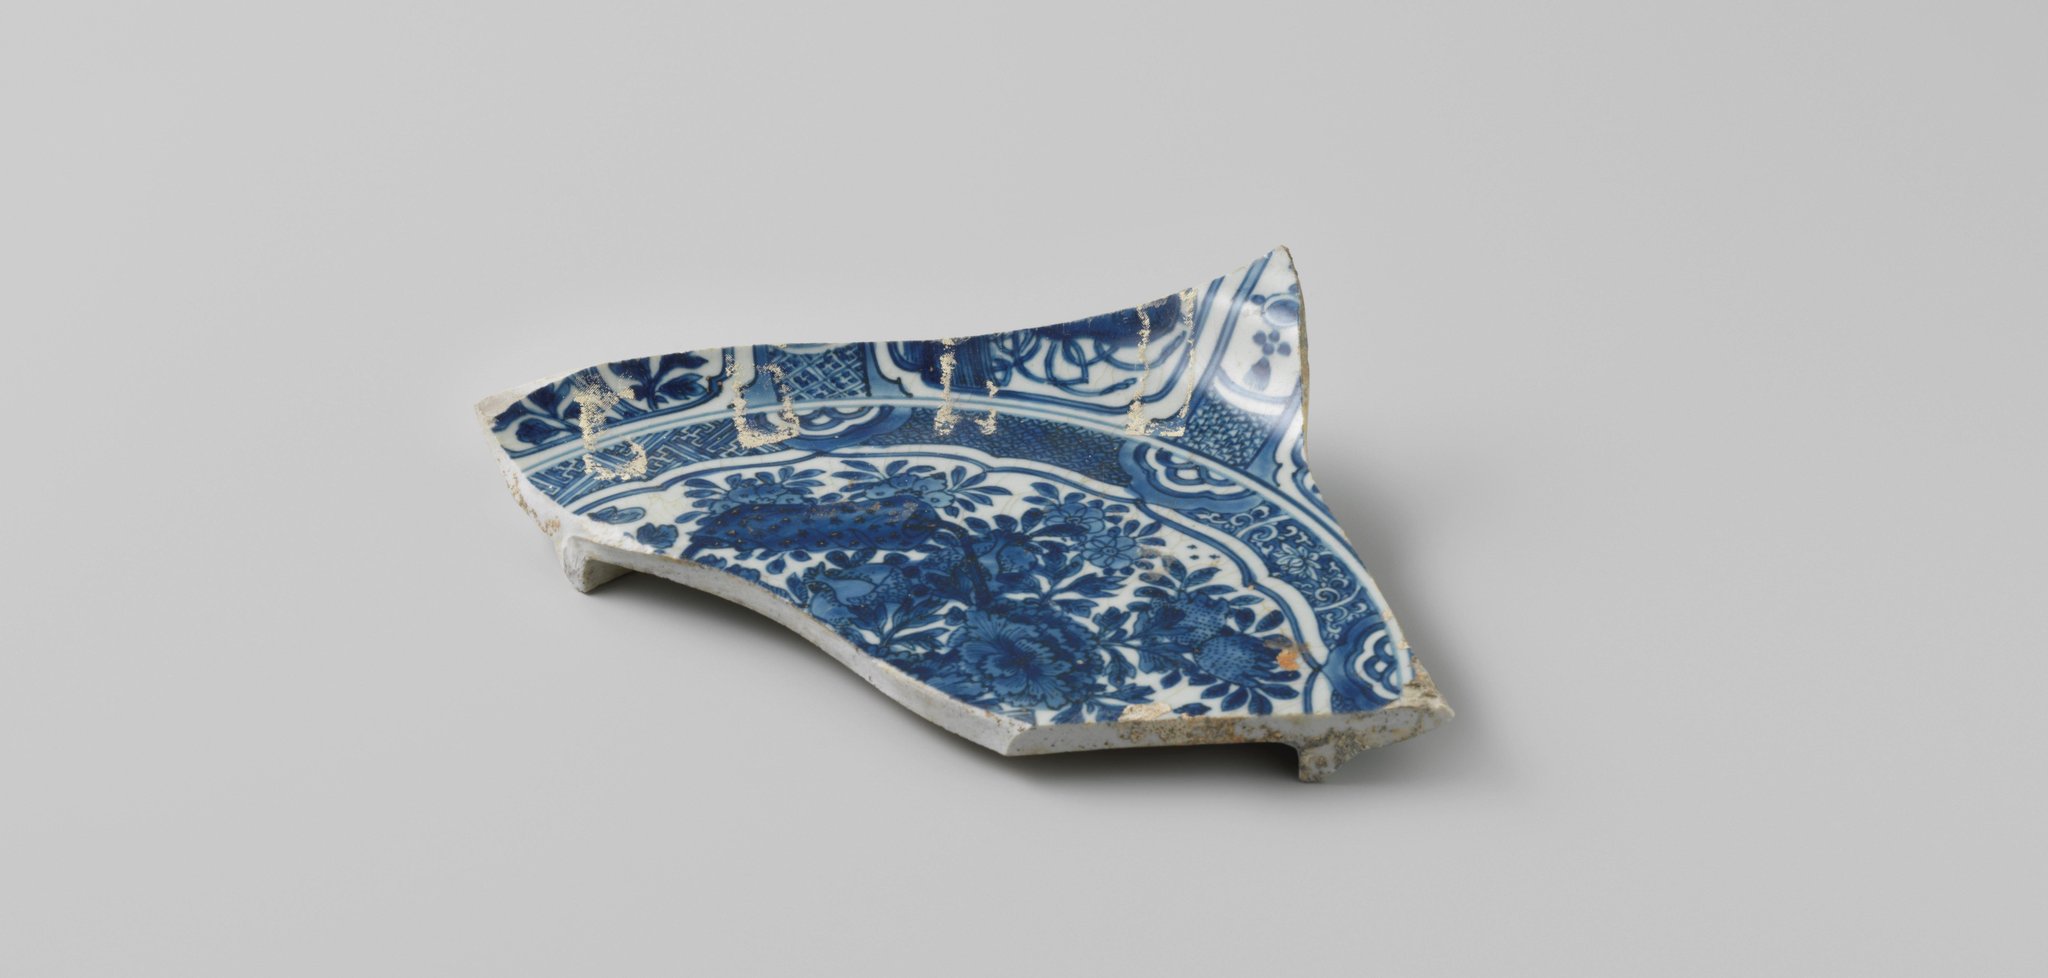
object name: plate dish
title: Scherven van borden uit V.O.C.-schip de 'Witte Leeuw'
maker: Anonymous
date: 1613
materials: bone china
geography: jingdezhen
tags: verenigde oostindische compagnie, sint-helena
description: Scherven van borden uit V.O.C.-schip de 'Witte Leeuw'.